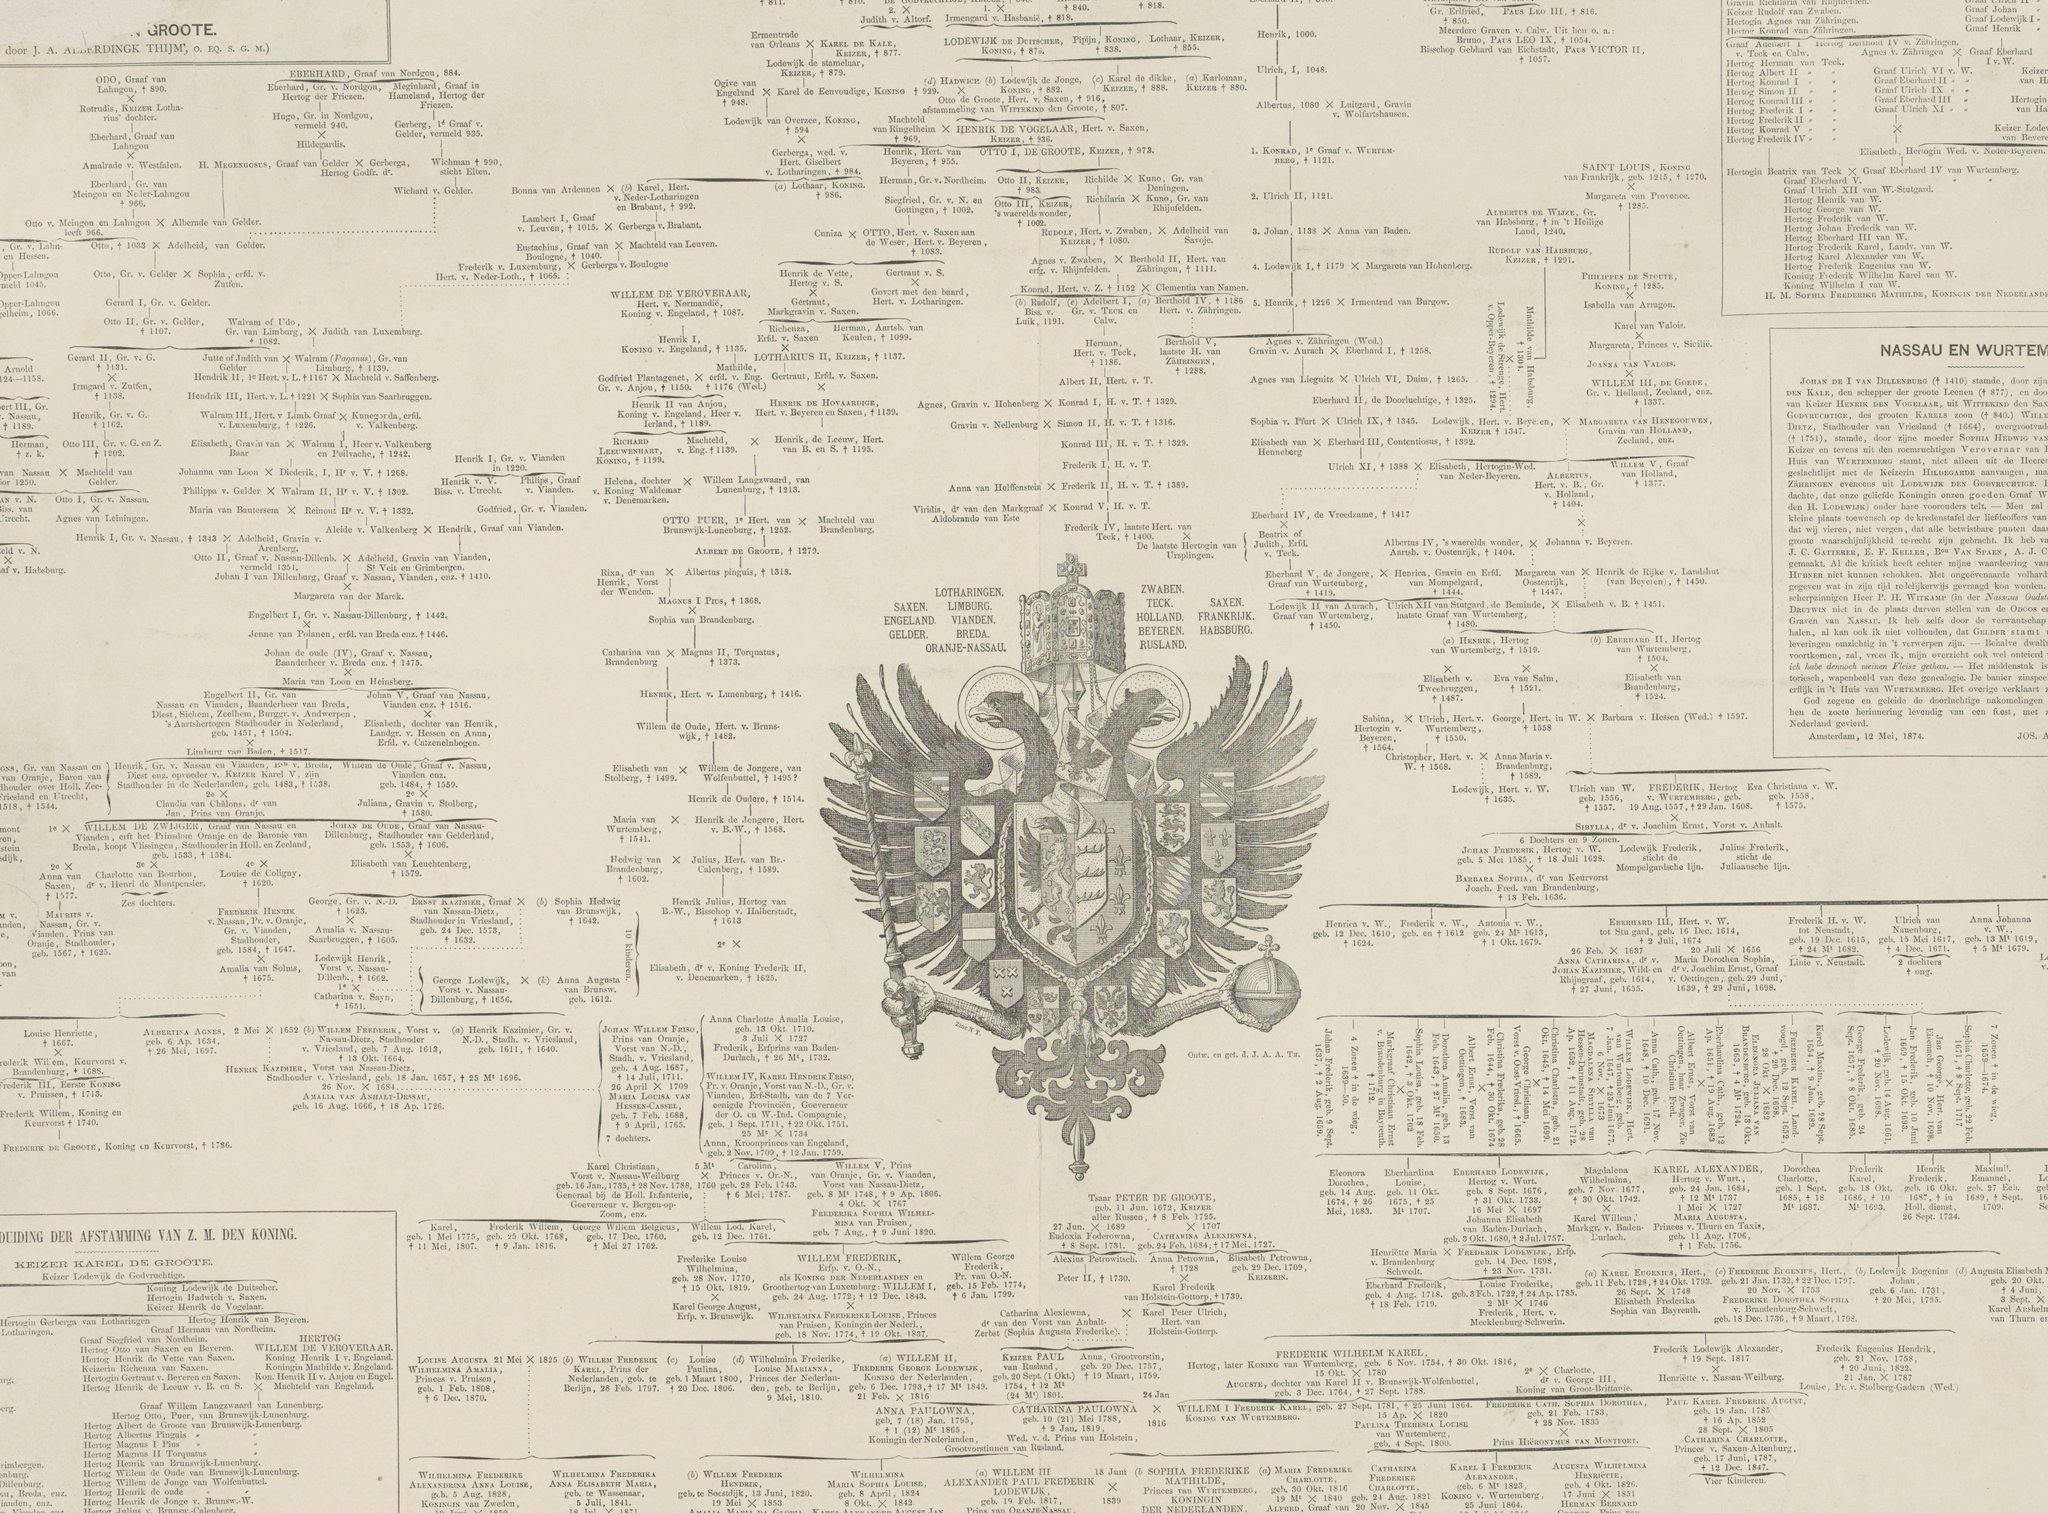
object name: print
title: Stamboom van Willem III, koning der Nederlanden, en Sophie van Württemberg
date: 1874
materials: paper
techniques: letterpress printing, engraving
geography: amsterdam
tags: brussels, willem iii (koning der nederlanden), the hague, sophia frederika mathilda van württemberg, charlemagne (holy roman emperor), family lineage, pedigree, genealogical tree or table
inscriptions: date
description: Stamboom van Willem III en Sophie, van Karel de Grote tot en met 1874. In het midden meerdere wapens en een tweekoppige adelaar met een kroon, een scepter en de rijksappel. Daar omheen namen, titels, geboortedata, trouwdata en sterfdata in boekdruk.